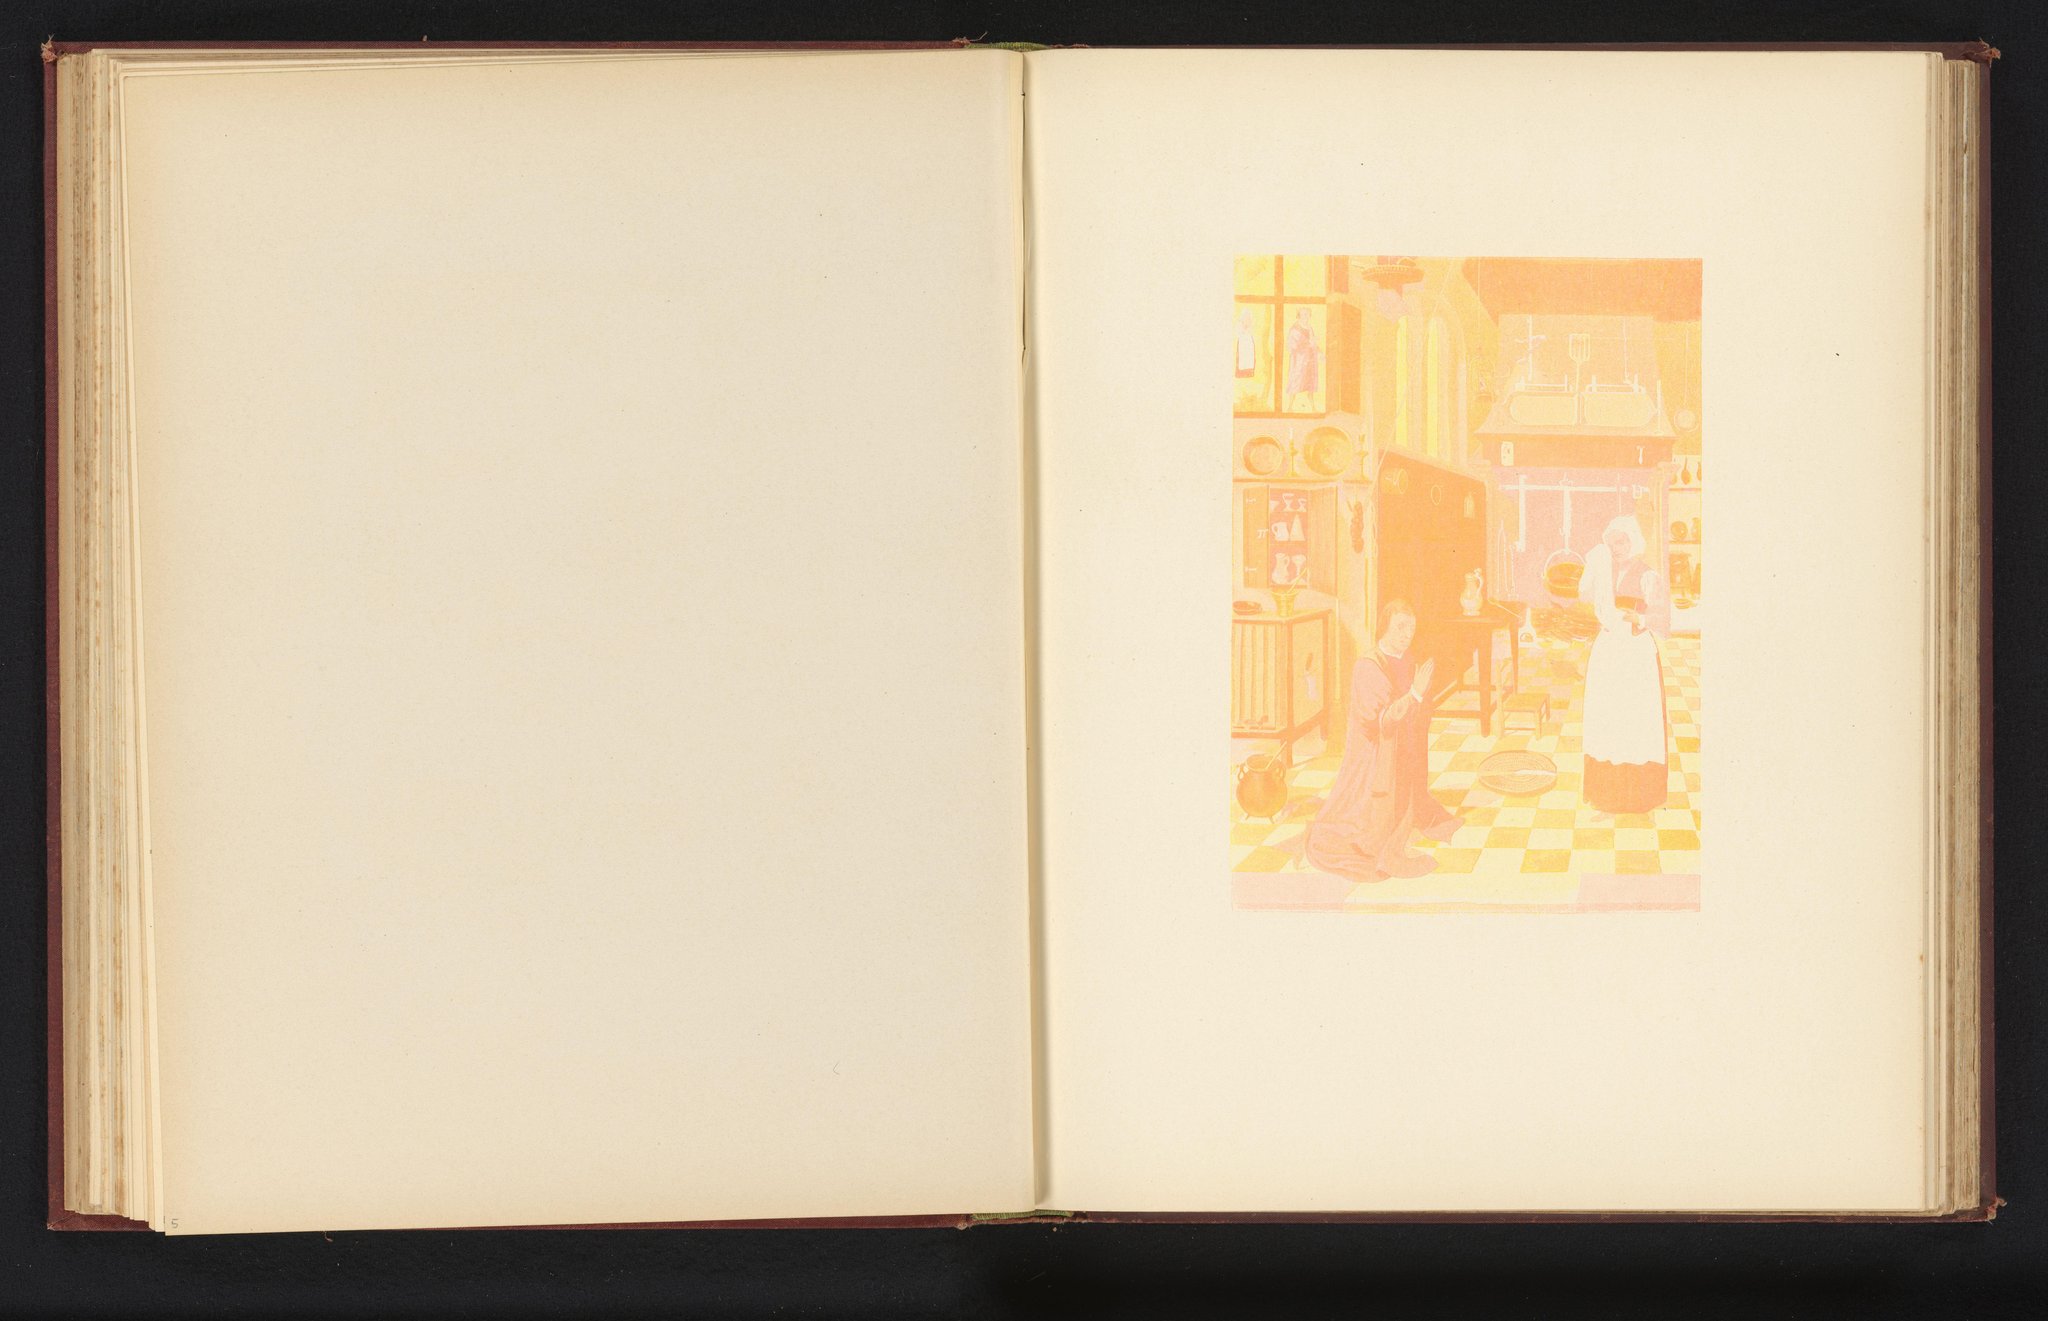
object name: print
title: Reproductie van het schilderij Het mirakel van de gebroken zeef, meerkleurig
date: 1889-1894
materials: paper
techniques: chromolithography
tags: kitchen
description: Prent op zevende ongenummerde pagina na pagina 104.